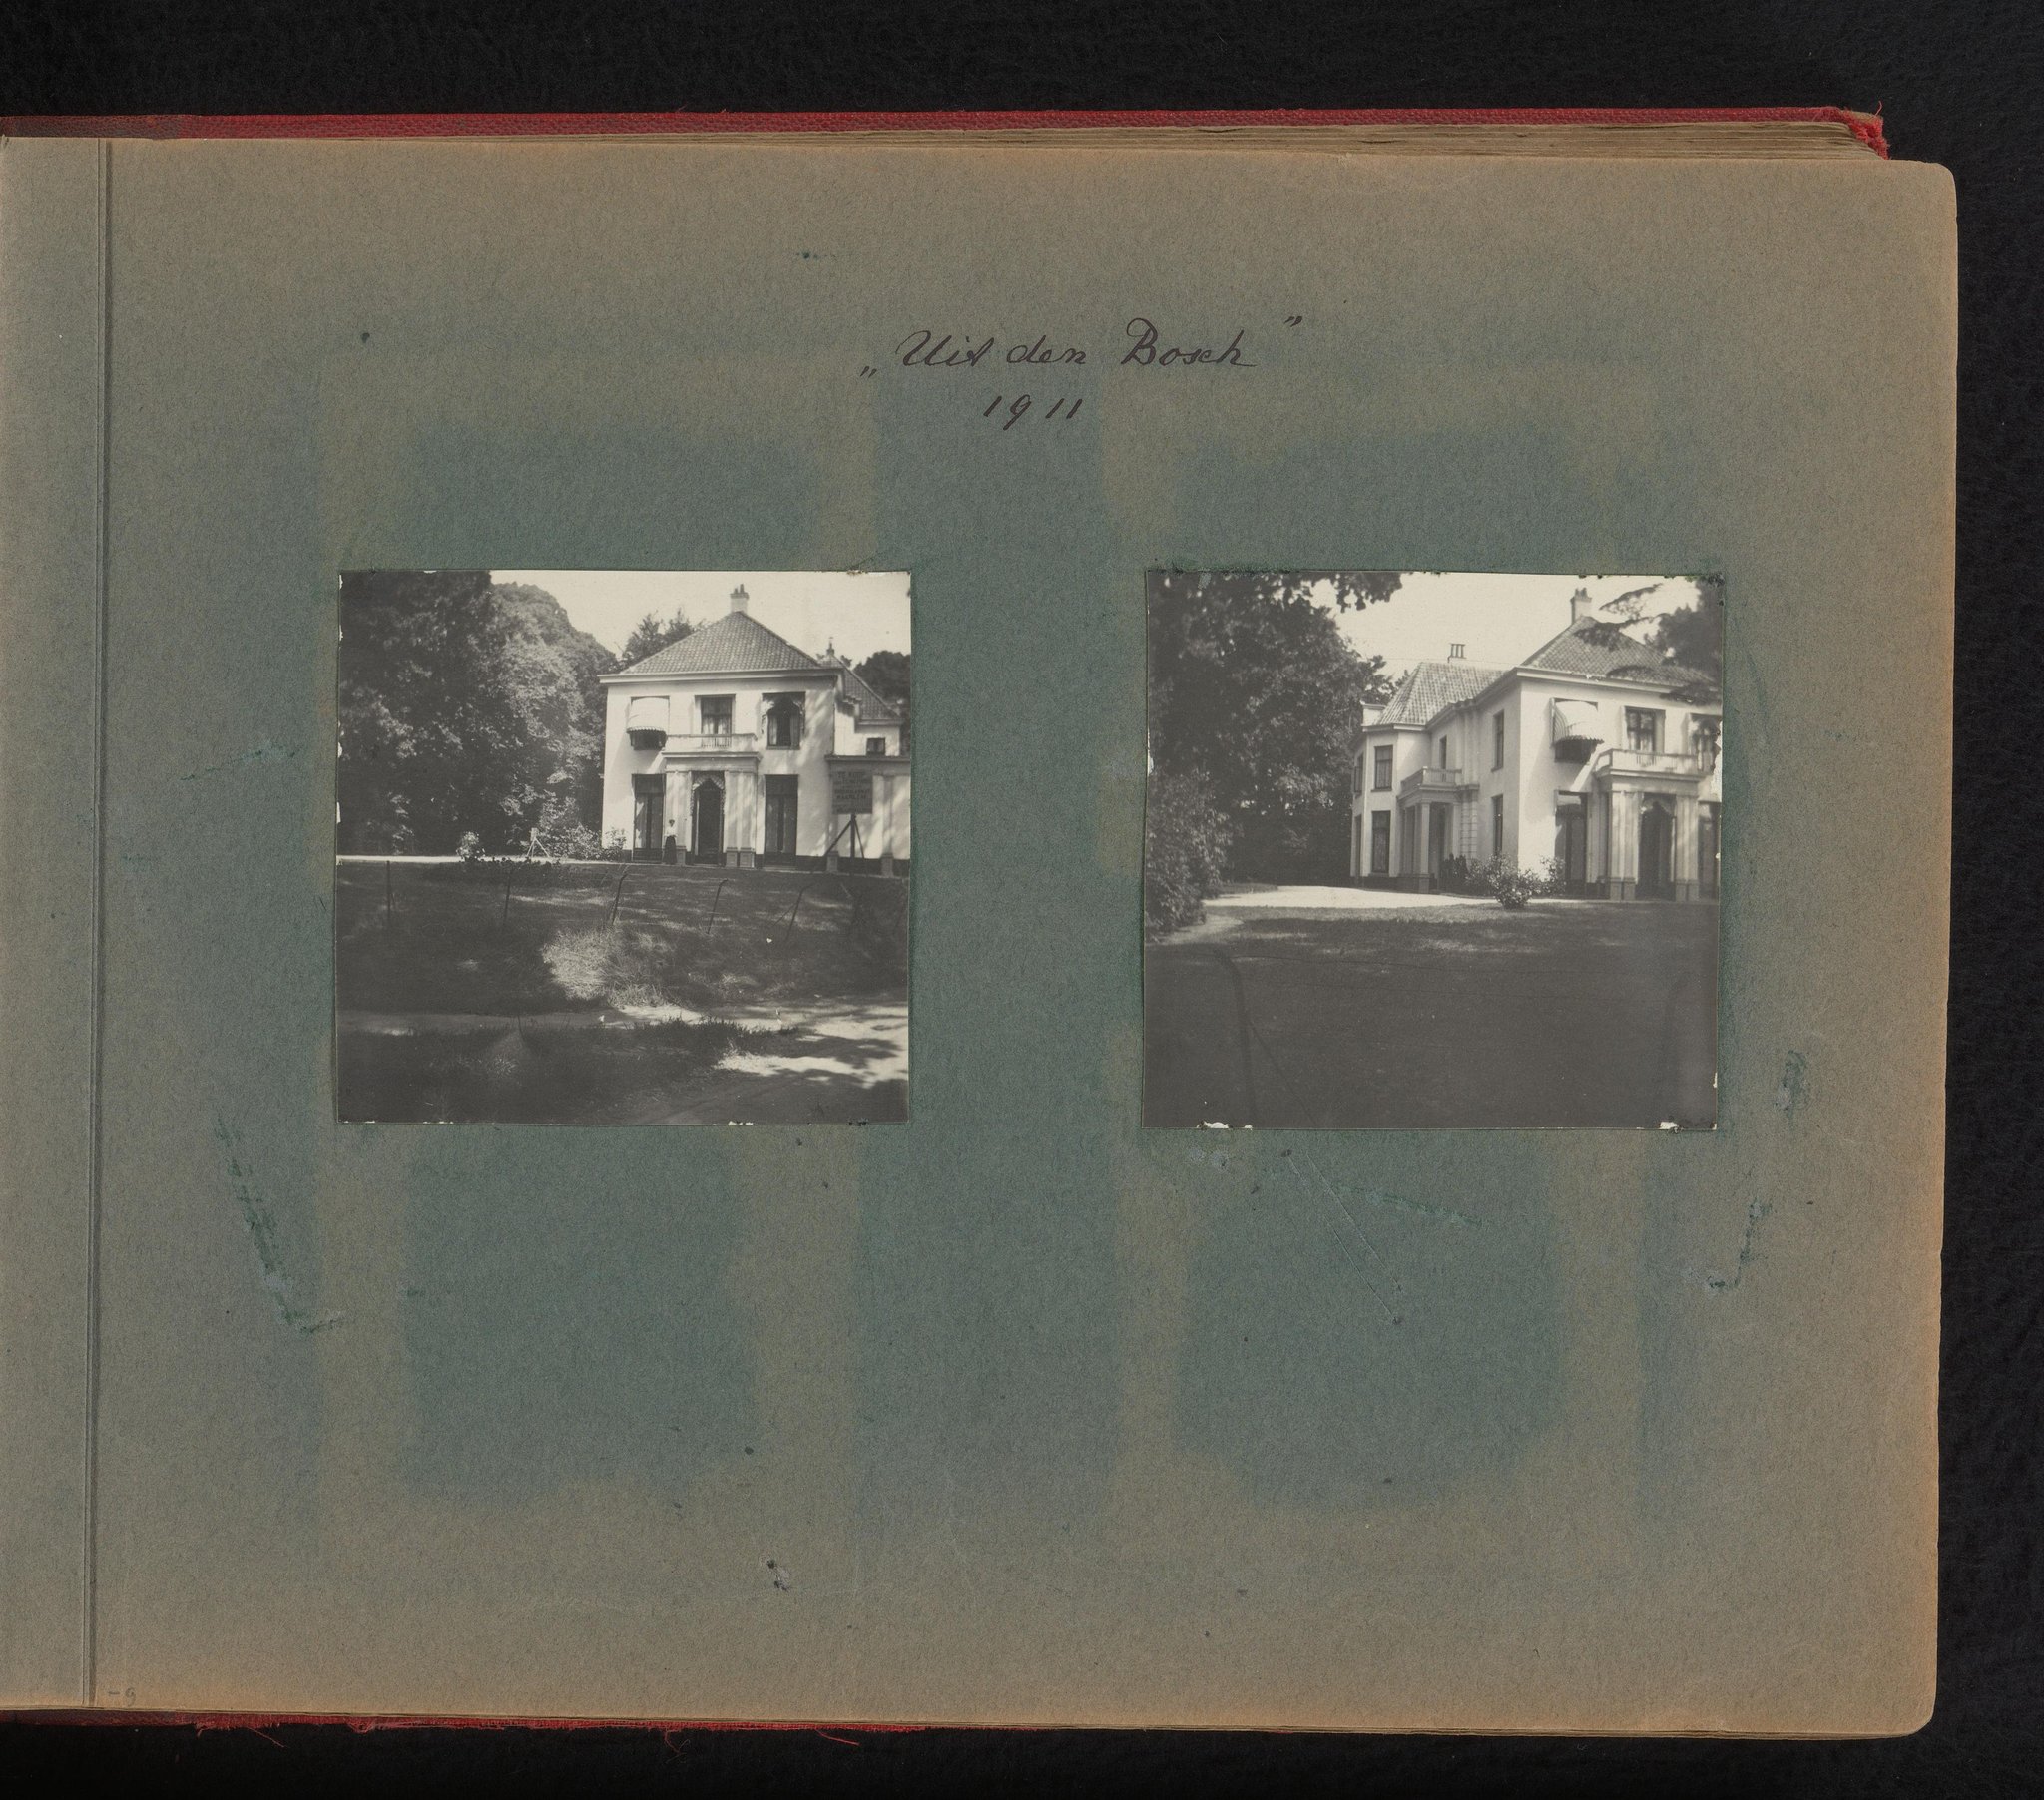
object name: album leaf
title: Twee gezichten op een landhuis, vermoedelijk in Den Bosch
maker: charlotte alida boelen-matthes (lot)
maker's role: amateurfotograaf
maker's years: 1889-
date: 1911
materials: paper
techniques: gelatin silver print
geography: den bosch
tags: villa, den bosch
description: Deze foto's zijn onderdeel van een album.